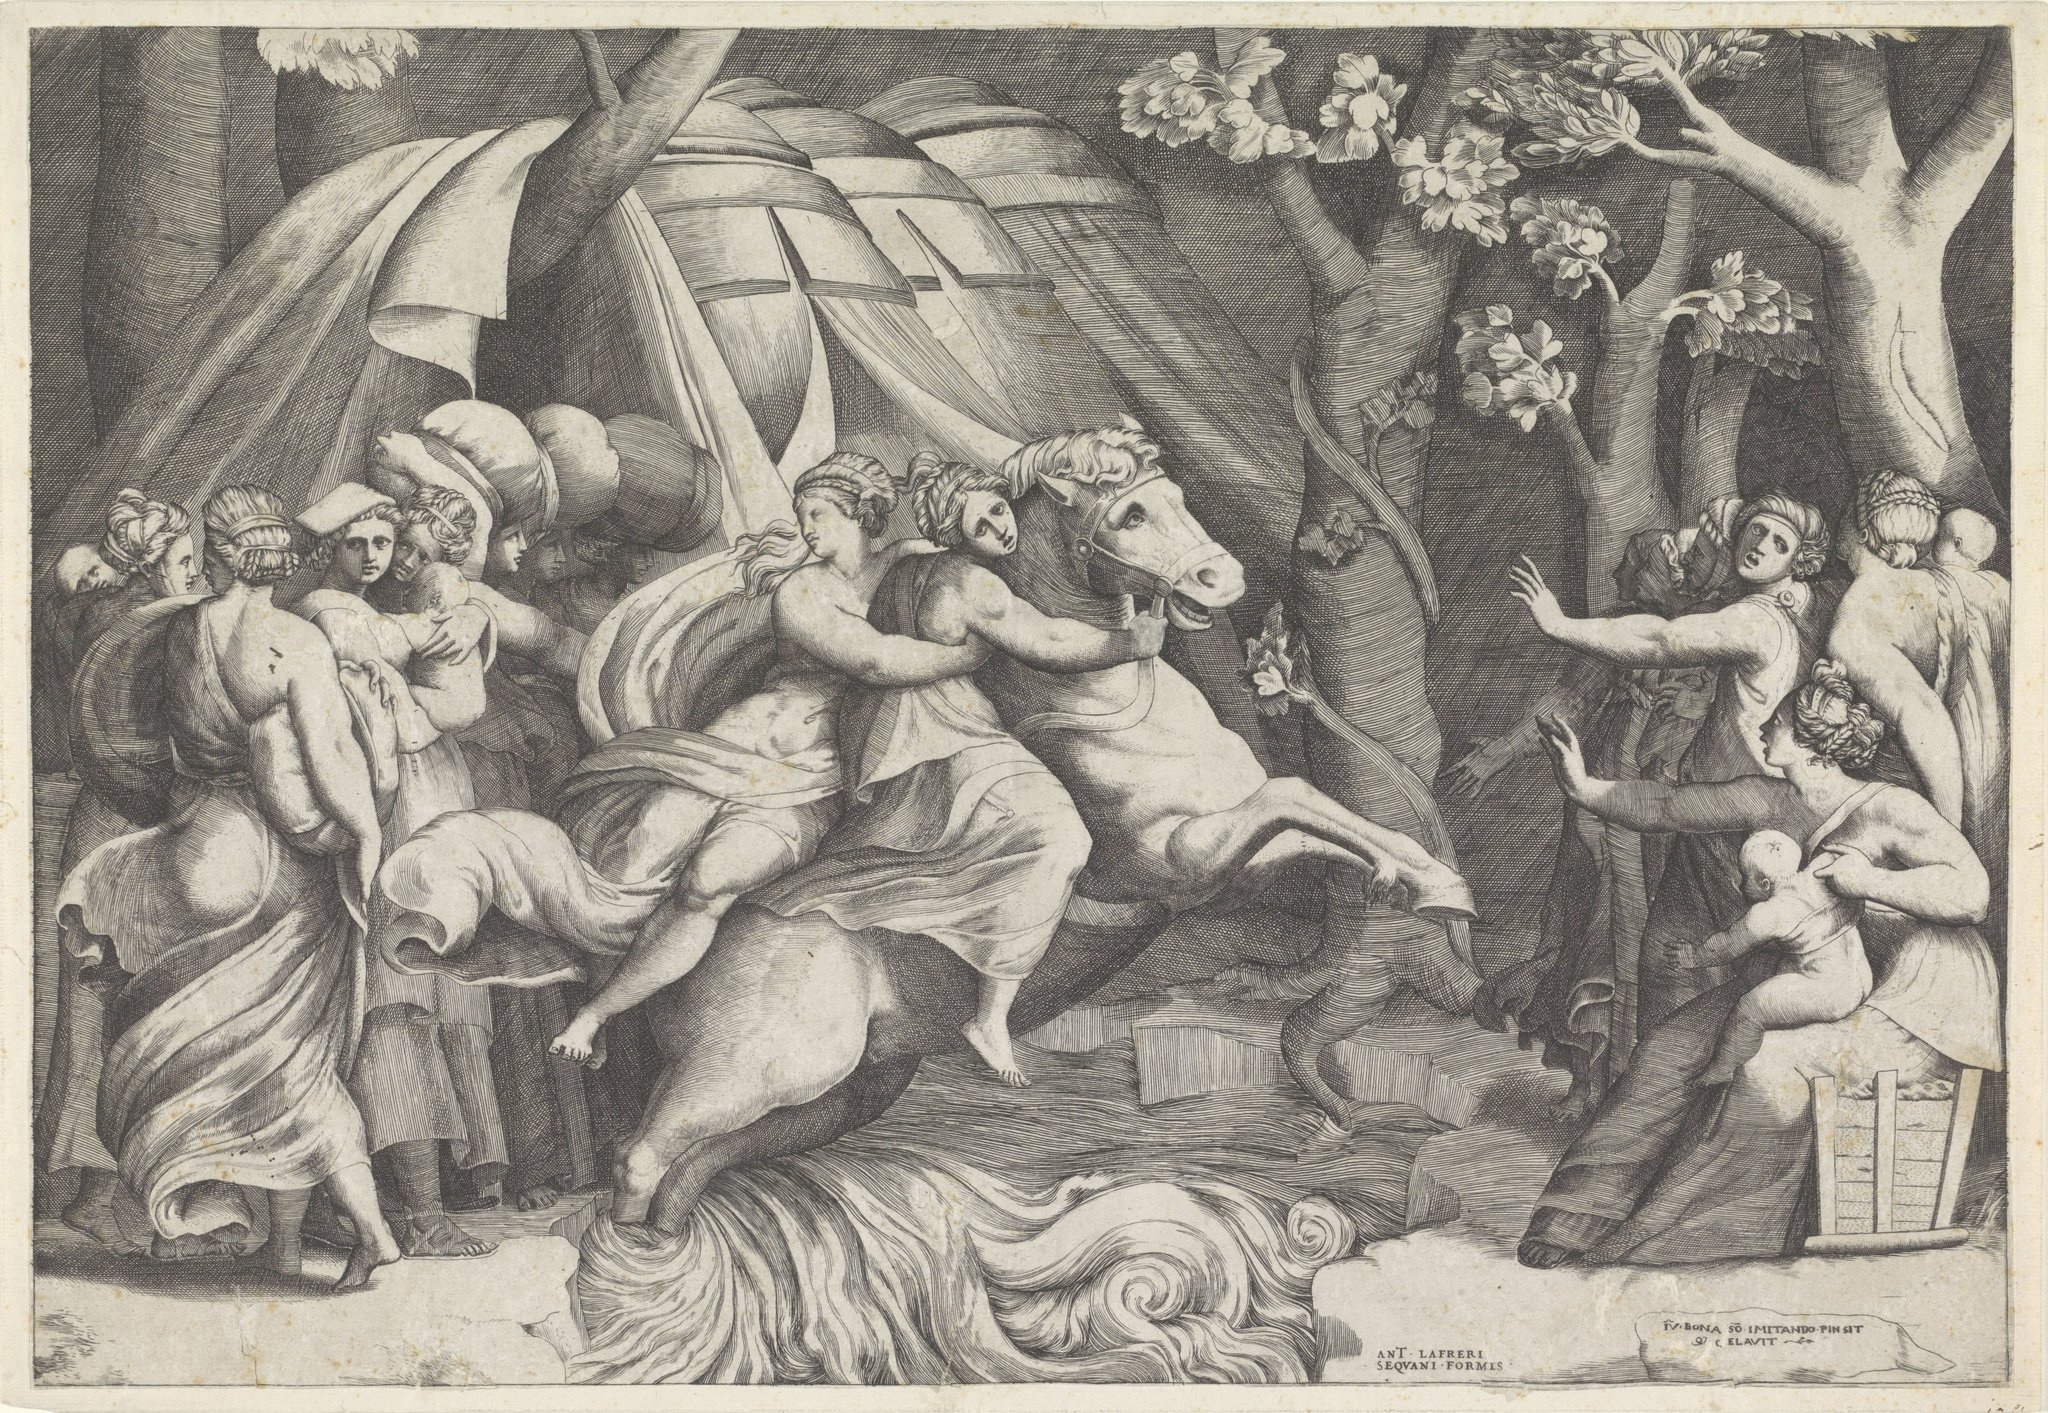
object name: print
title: Cloelia steekt de Tiber over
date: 1501-1580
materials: paper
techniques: engraving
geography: rome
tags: cloelia and her companions escape porsena's camp: she crosses the tiber on horseback and persuades her companions to swim after her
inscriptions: collector's mark: Lugt 2228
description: De uit gevangenschap ontsnapte Cloelia vlucht naar Rome. Ze steekt te paard de rivier de Tiber over. Links op de oever staat een groep vrouwen met kinderen voor tenten. Rechts staan vrouwen op de oever die Cloelia proberen tegen te houden.